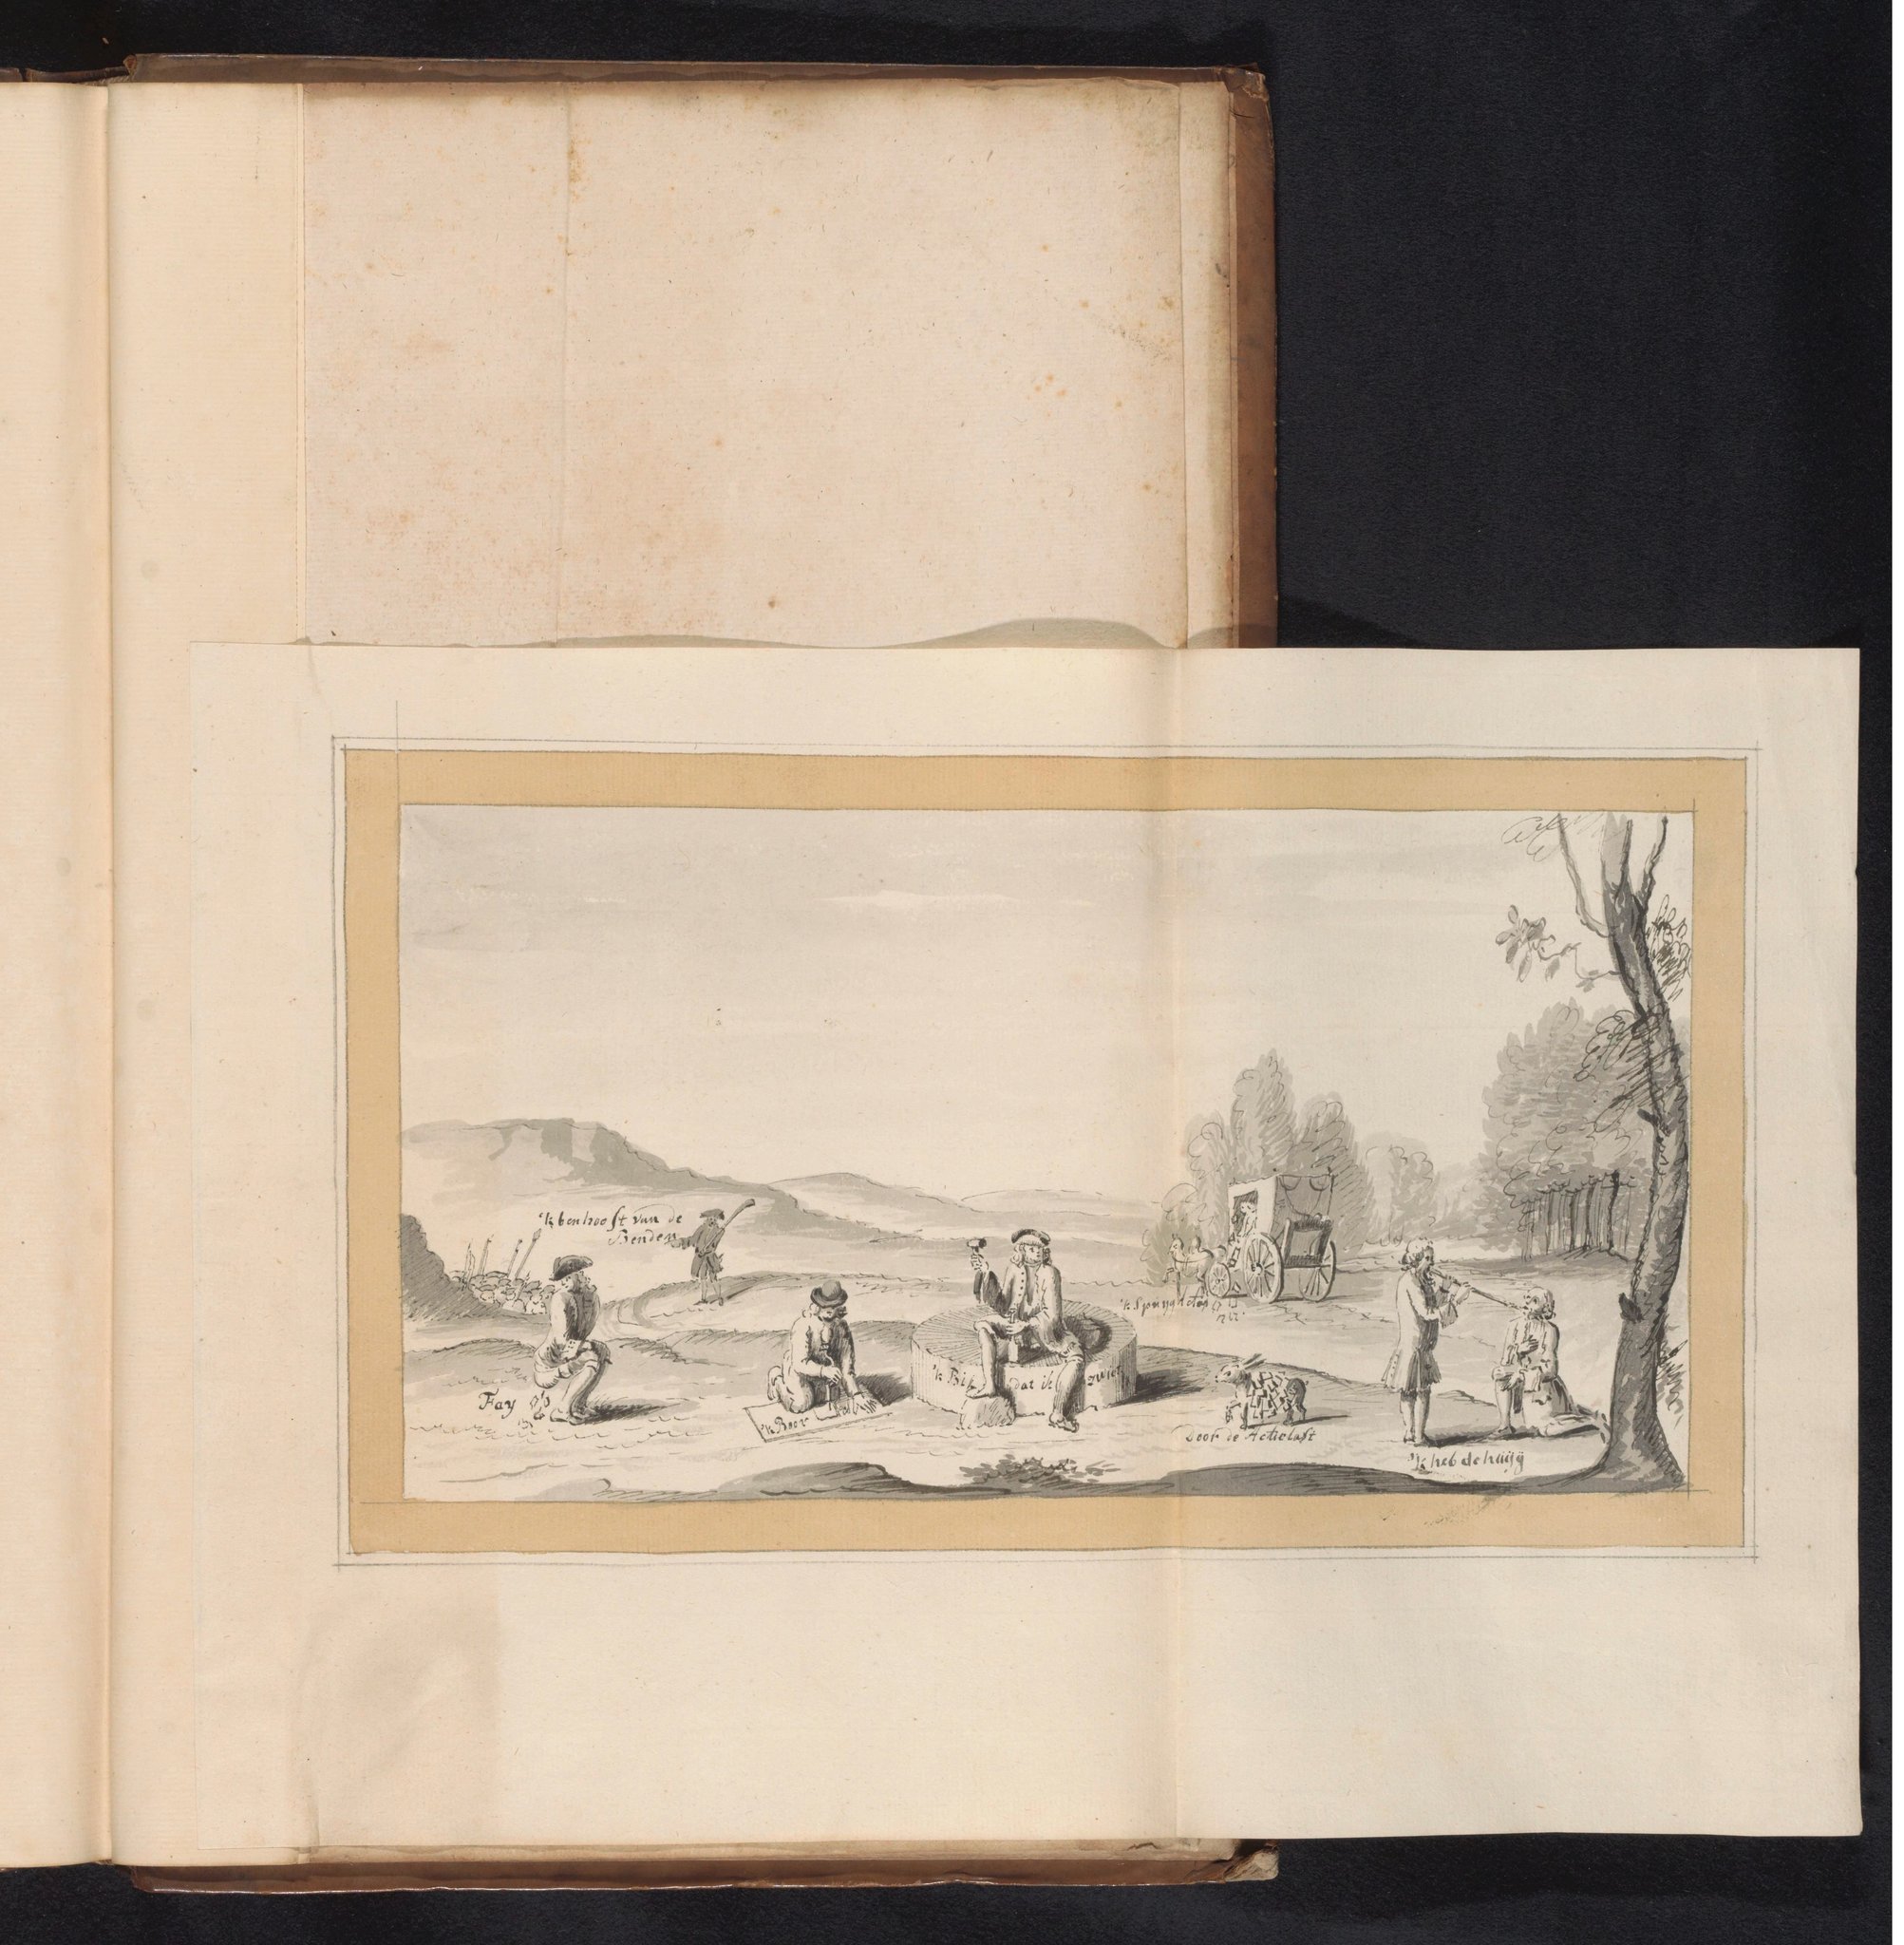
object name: drawing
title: De prysen van Actien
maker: Anonymous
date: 1720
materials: paper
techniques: drawing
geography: northern netherlands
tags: amsterdam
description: Ontwerptekening voor de spotprent op verschillende aanzienlijke Amsterdamse families die in de windhandel betrokken waren: Boreel, Bicker van Swieten, Hooft, Fay en anderen. Behoort tot de groep van extra stukken meegebonden in de gebonden eerste uitgave (304 B 11) van Het Tafereel der Dwaasheid met spotprenten op de Windhandel of Actiehandel van 1720.